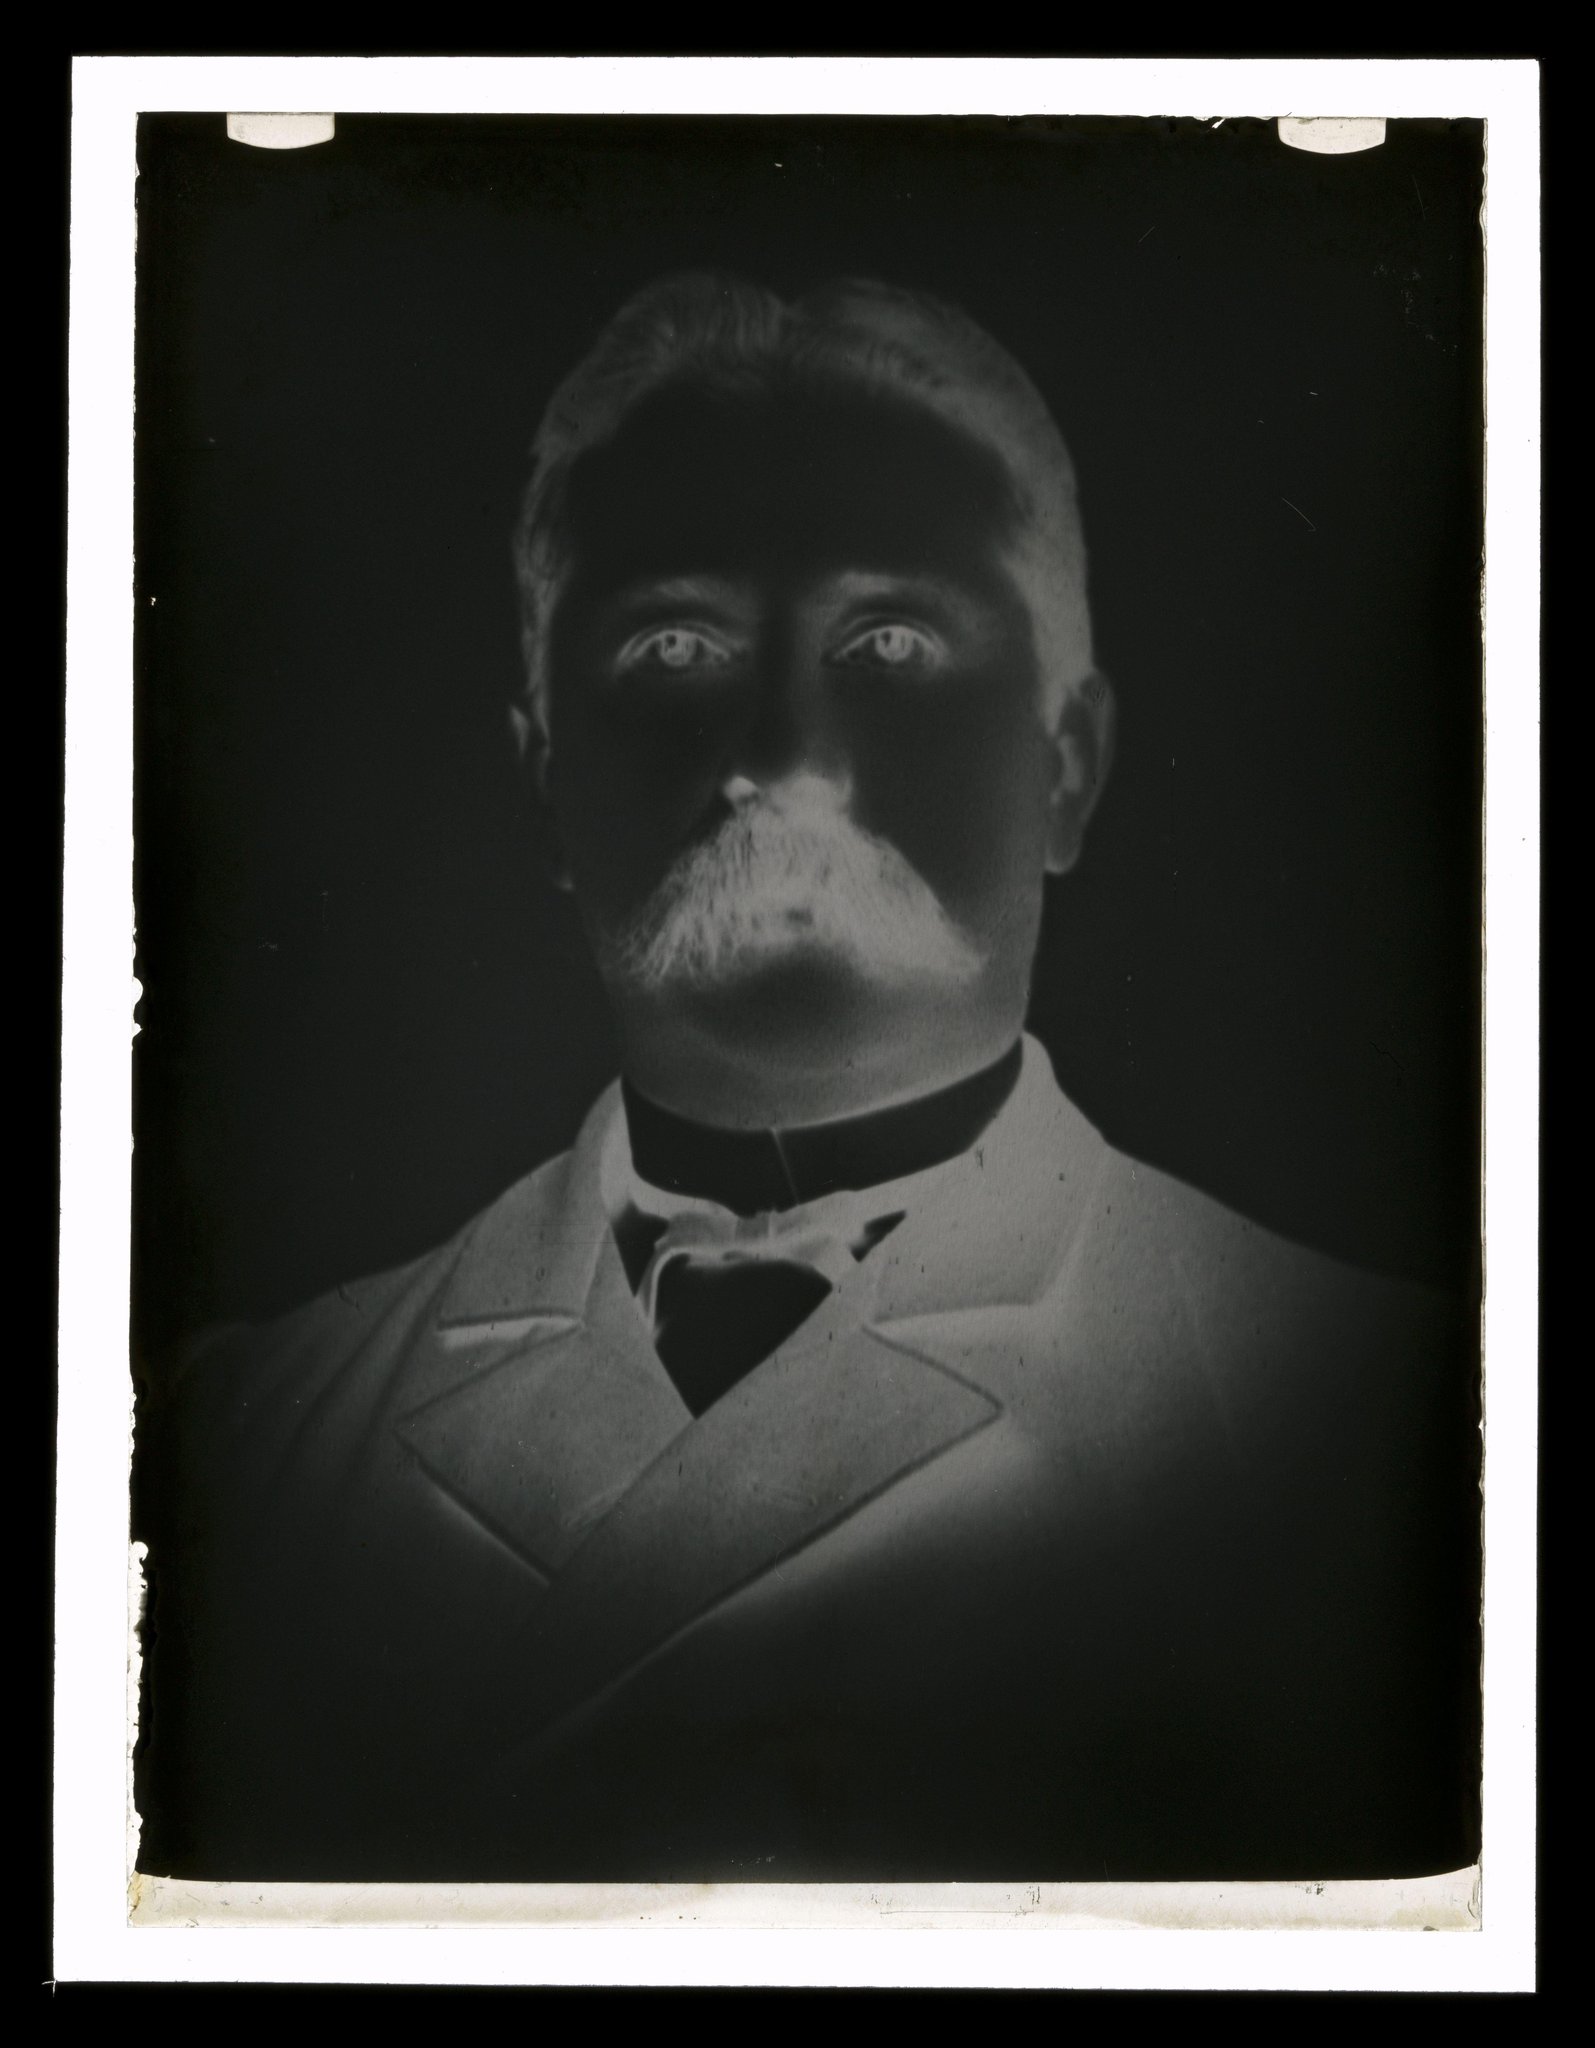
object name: glasnegatief, glasplaatnegatief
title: Portret van een onbekende man met snor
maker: Anonymous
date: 1907-1935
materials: glass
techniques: gelatin glass negative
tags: moustache, historical persons not known by name